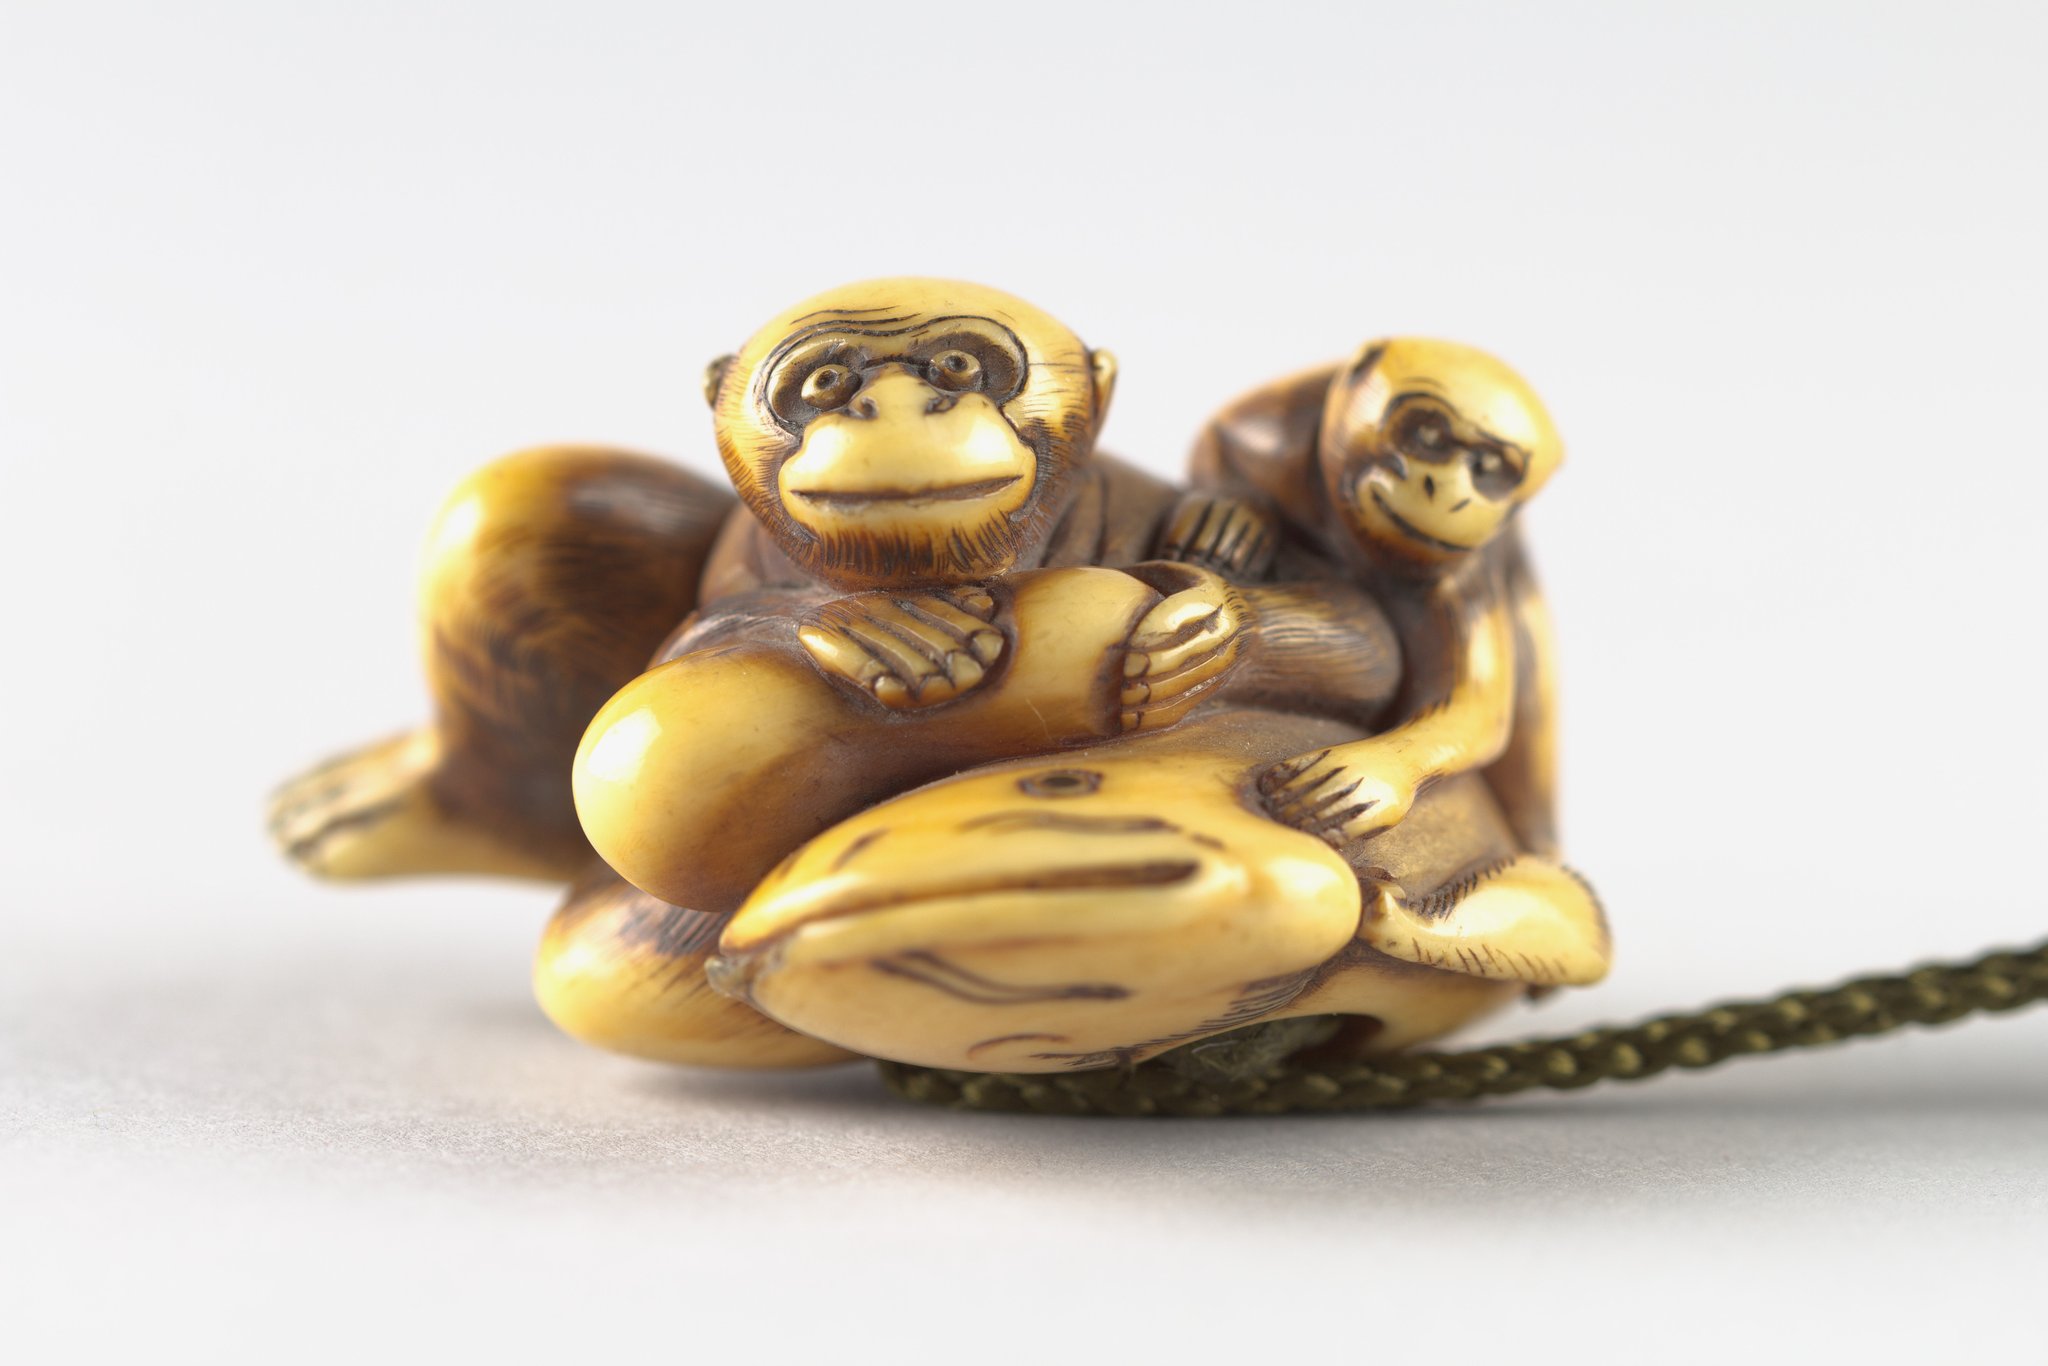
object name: netsuke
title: Netsuke with Decoration of Monkeys and Catfish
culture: japanese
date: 1801-1900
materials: ivory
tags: fish,monkeys